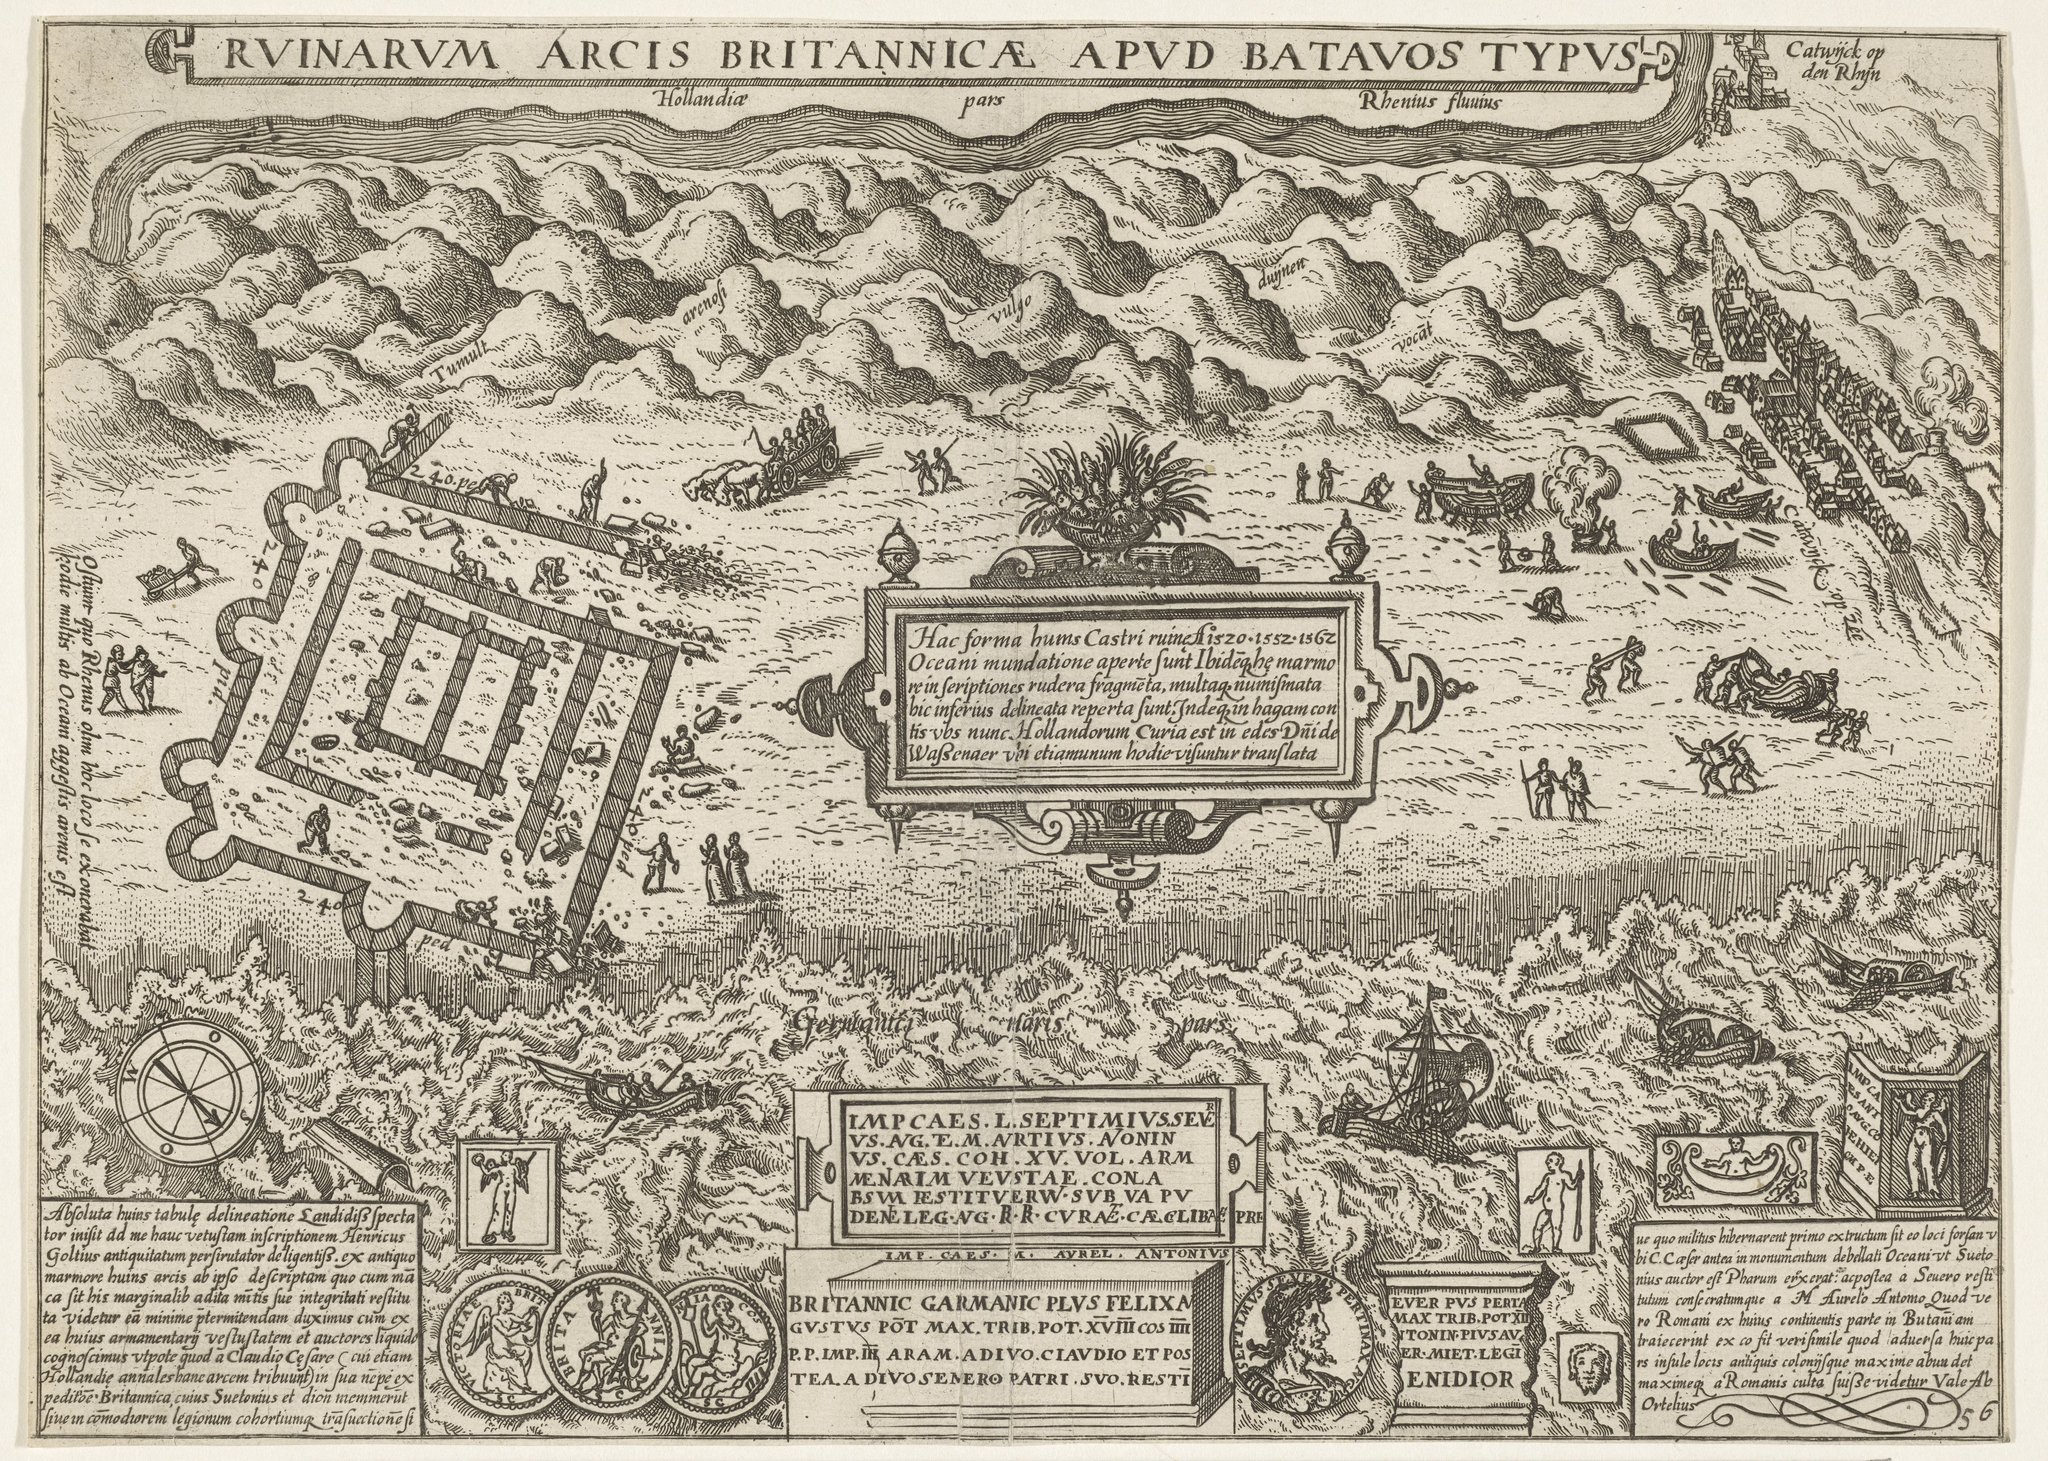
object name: print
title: Kustlandschap met de fundamenten van het Huis te Britten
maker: Anonymous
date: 1607-1609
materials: paper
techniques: etching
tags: landscape with ruins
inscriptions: collector's mark: Lugt 2228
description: Gebruikt als illustratie eerst in: L. Guicciardini, Description de touts les Pays-Bas, autrement appellez la Germanie Inférieure ou Basse Allemagne, Cornelis Claesz., Amsterdam 1609. In deze tweede staat gebruikt in: L. Guicciardini, Beschryvinghe van alle de Neder-landen, Willem Jansz. Blaeu, Amsterdam, 1612., nr. 56. Kopie naar de oorspronkelijke illustratie in de uitgave van 1581 van C. Plantijn.